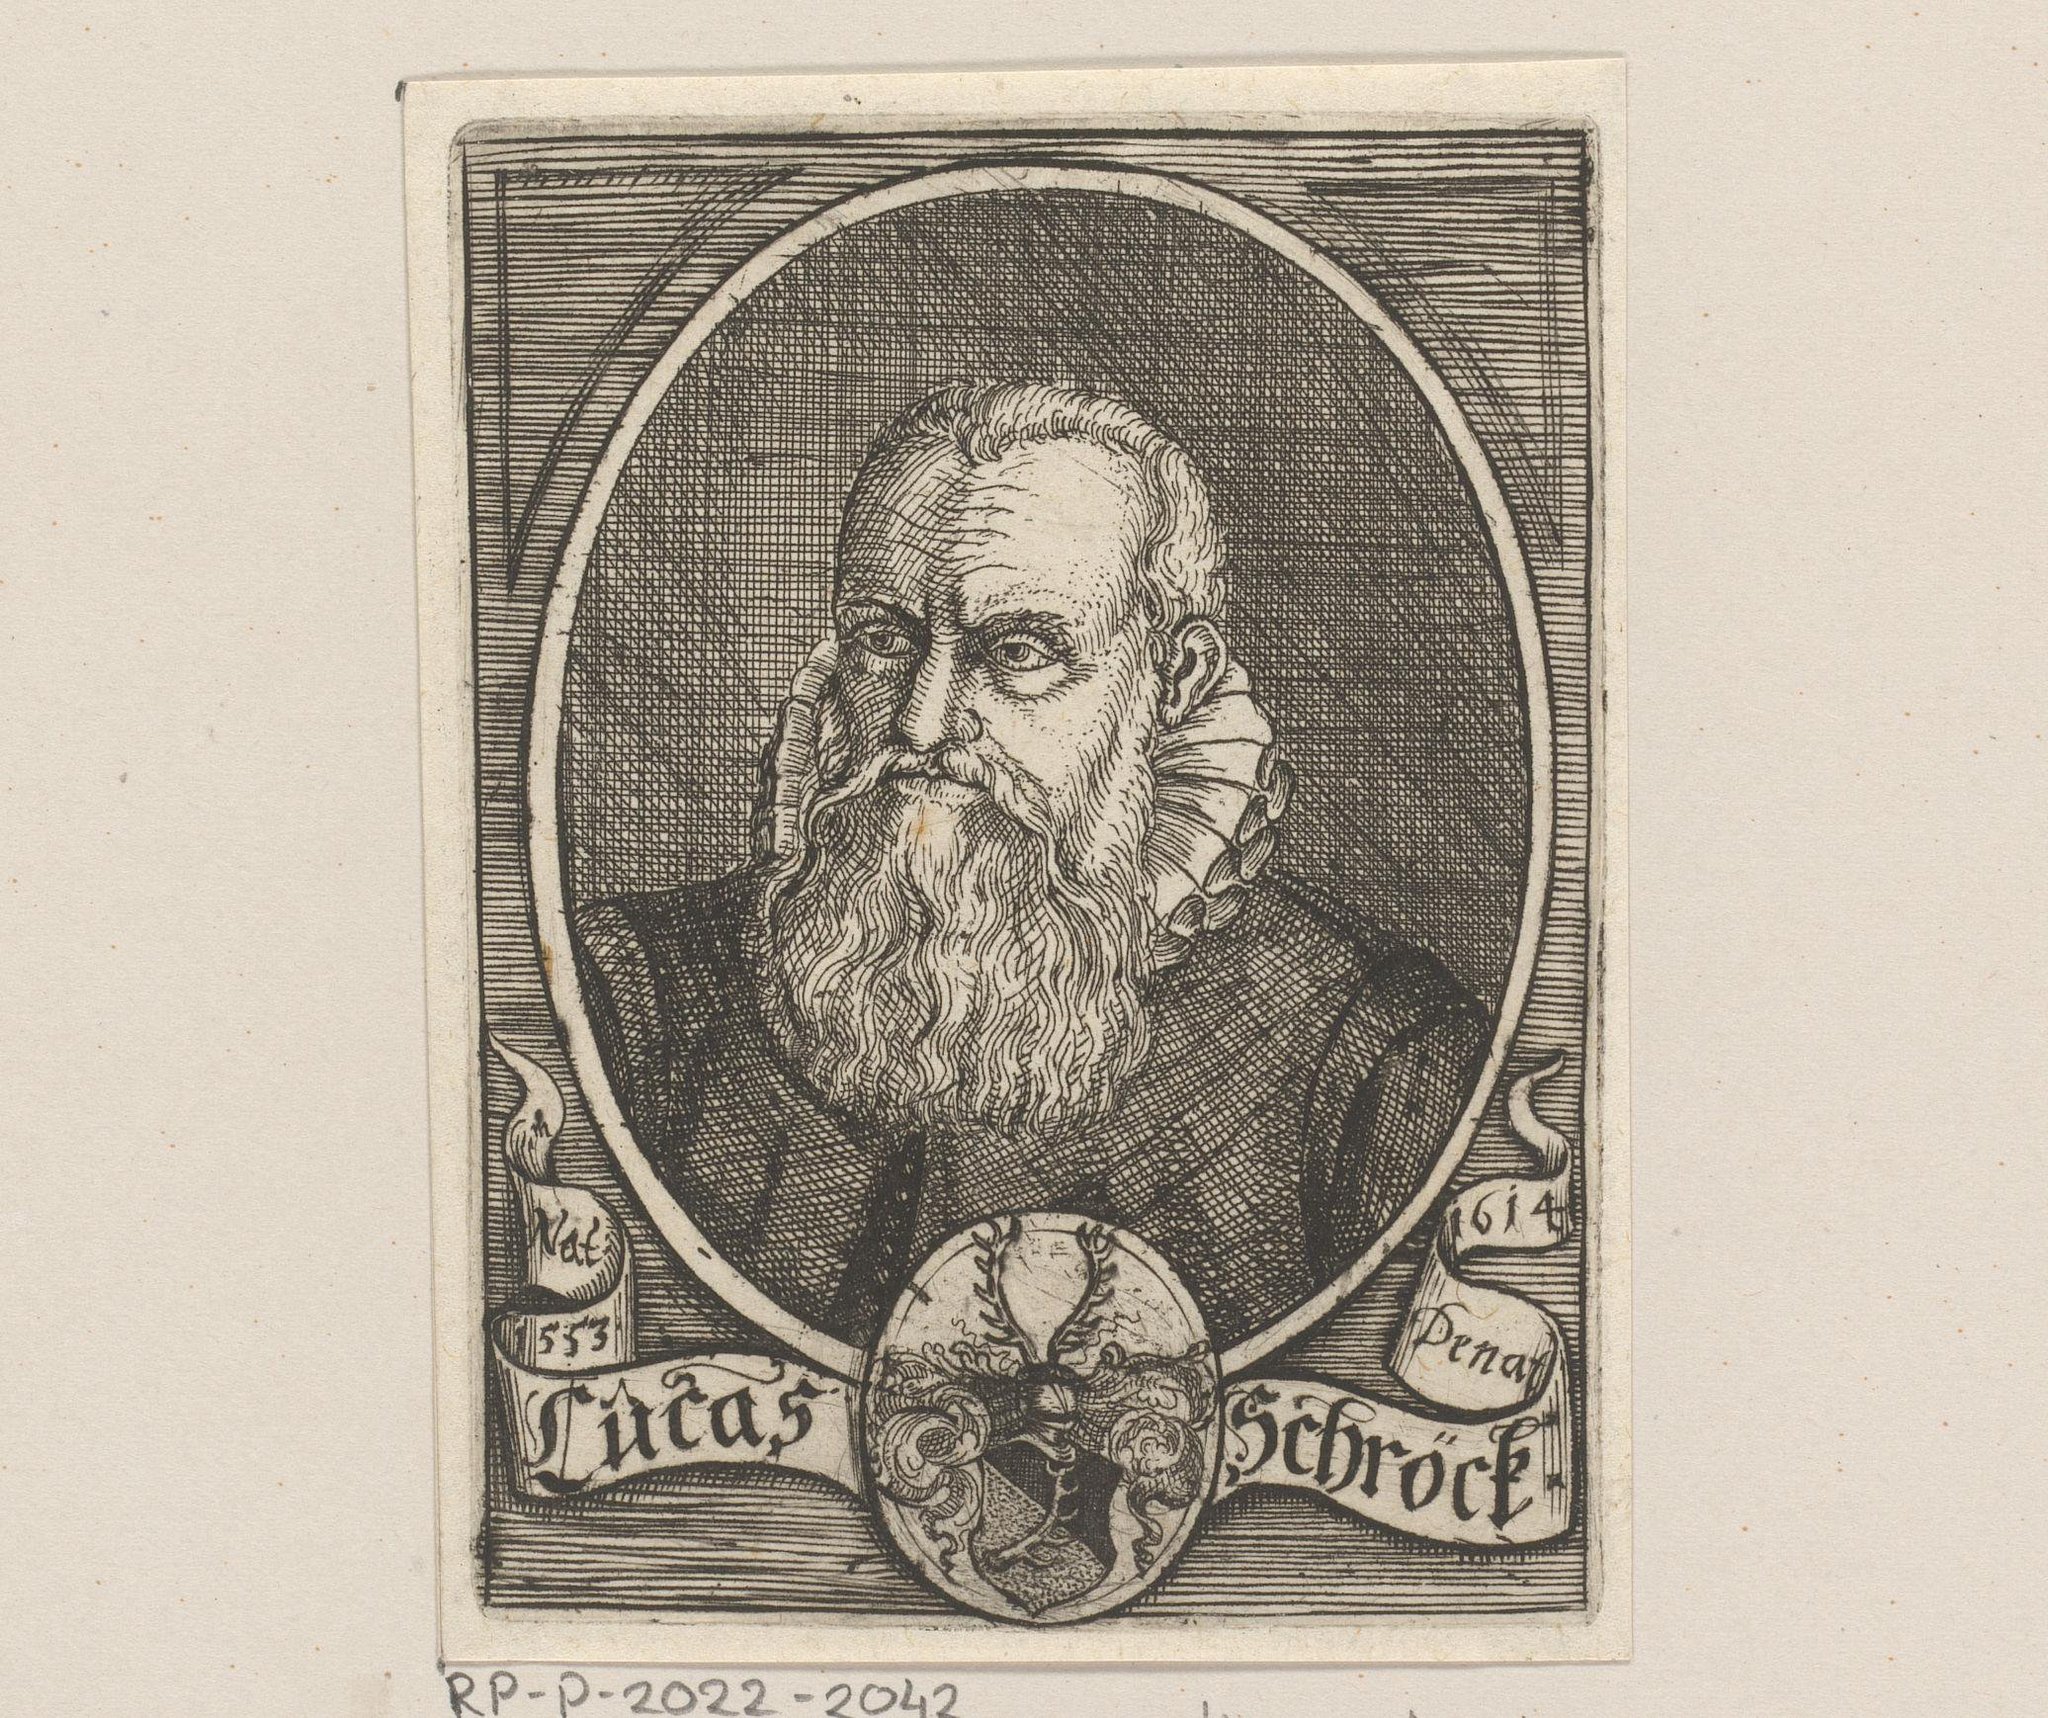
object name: print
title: Portret van Lucas Schröck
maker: johann reinhold mühl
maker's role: print maker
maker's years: 1631-1692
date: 1641-1692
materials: paper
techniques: etching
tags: historical persons, armorial bearing, heraldry